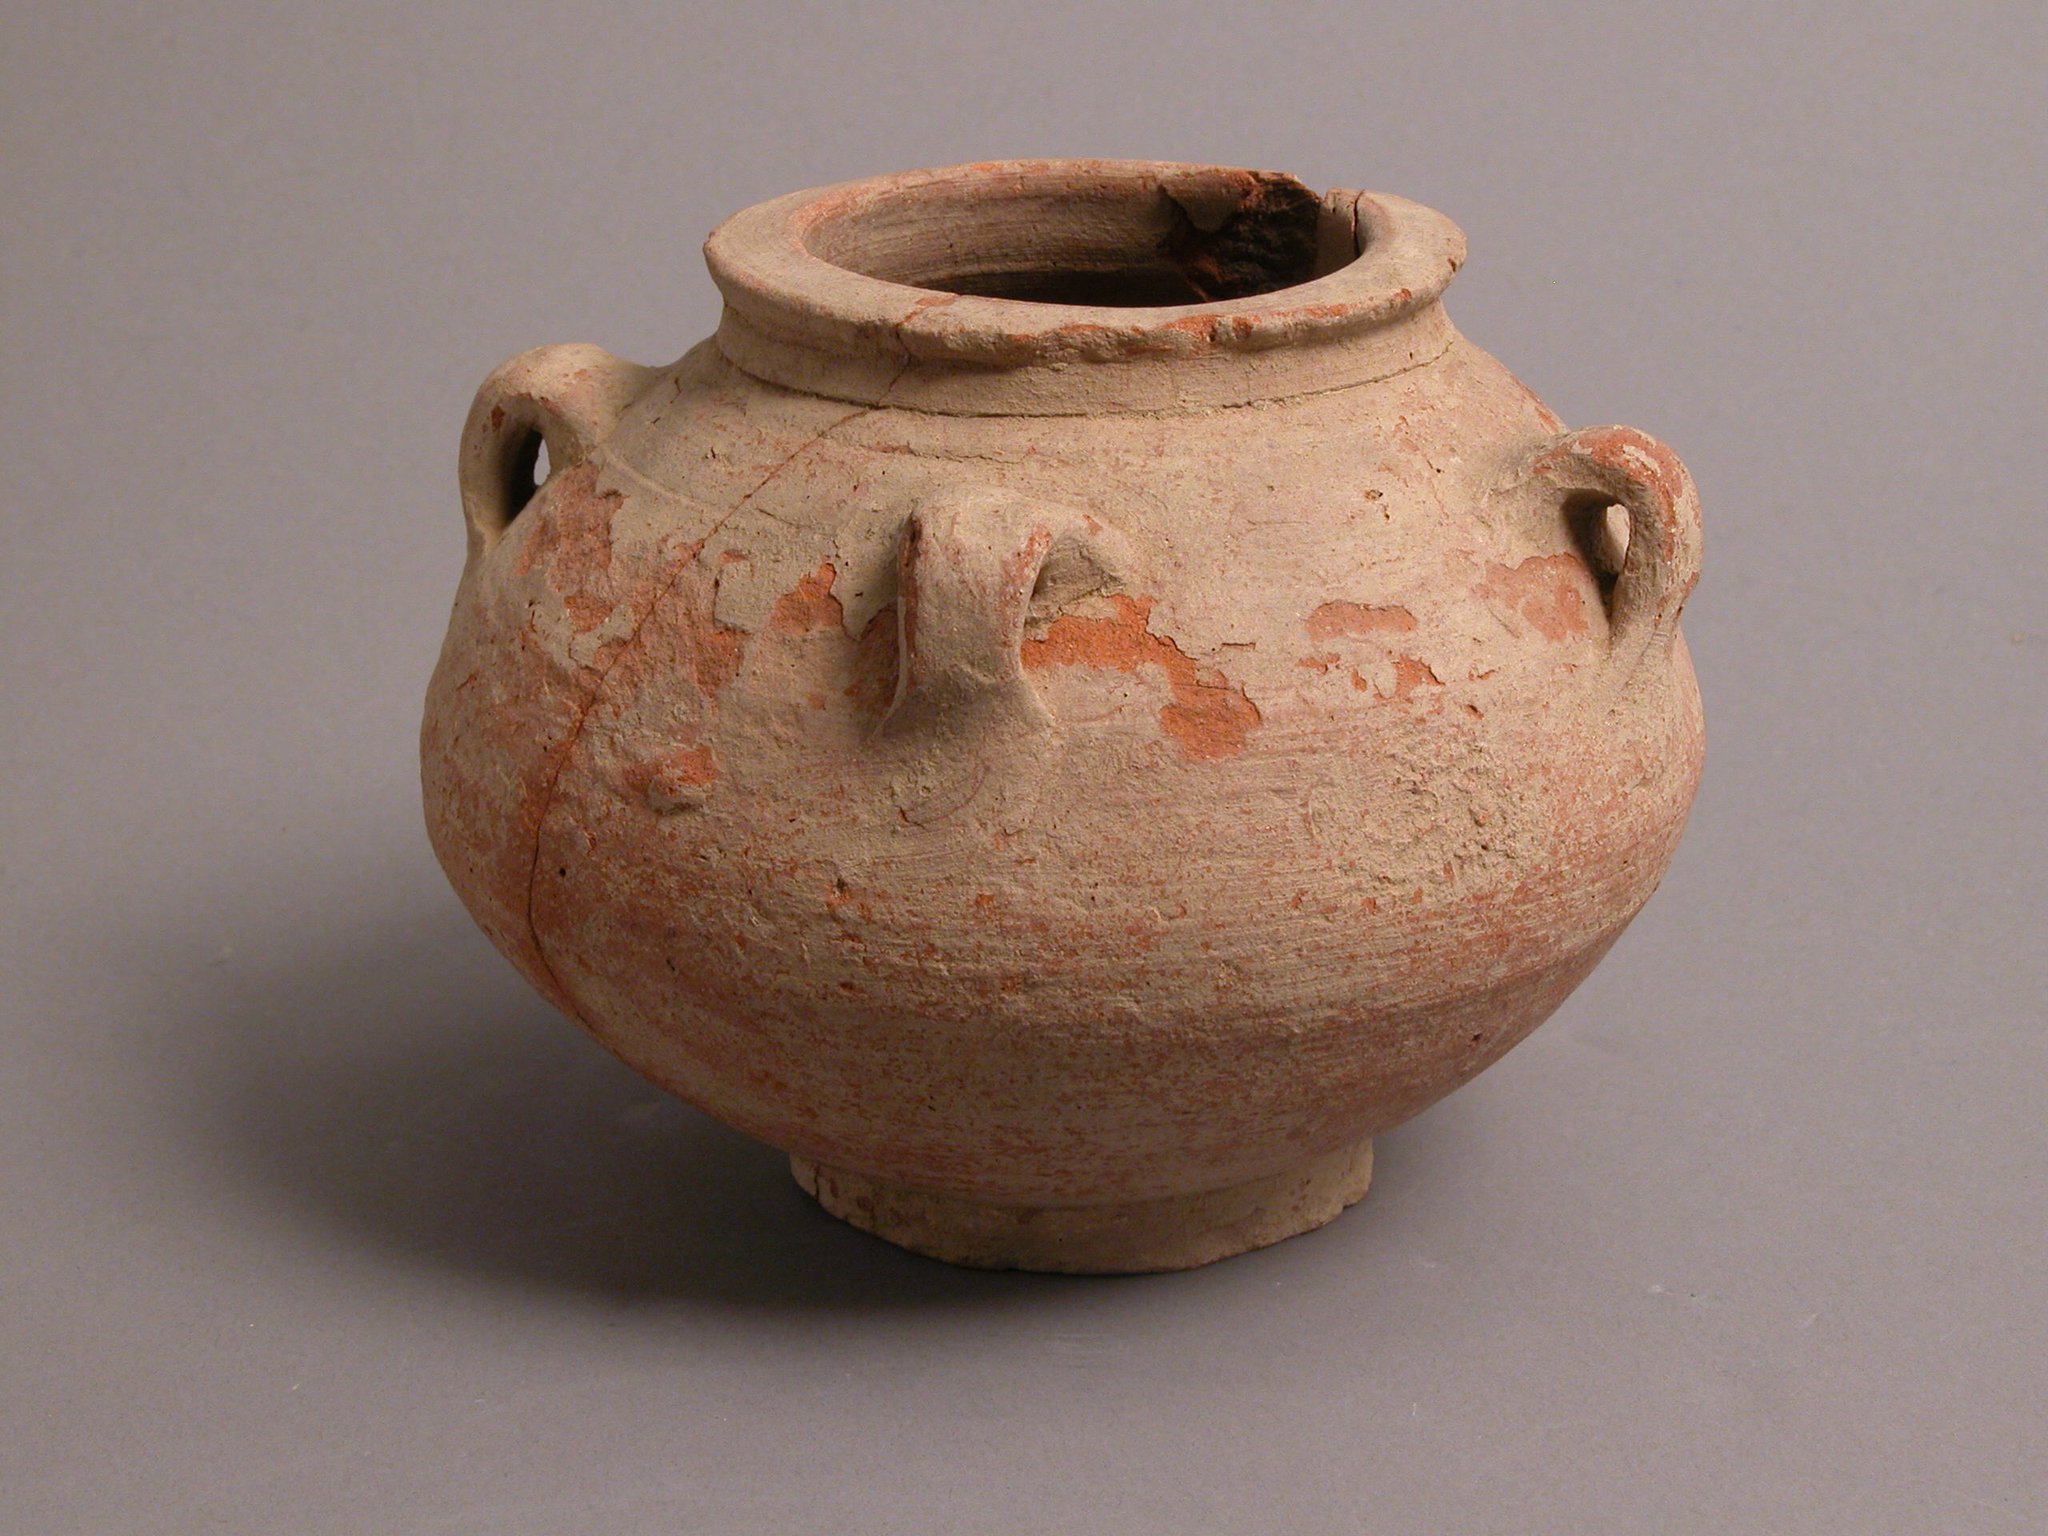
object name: vessel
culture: coptic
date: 301-700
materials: earthenware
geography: egypt